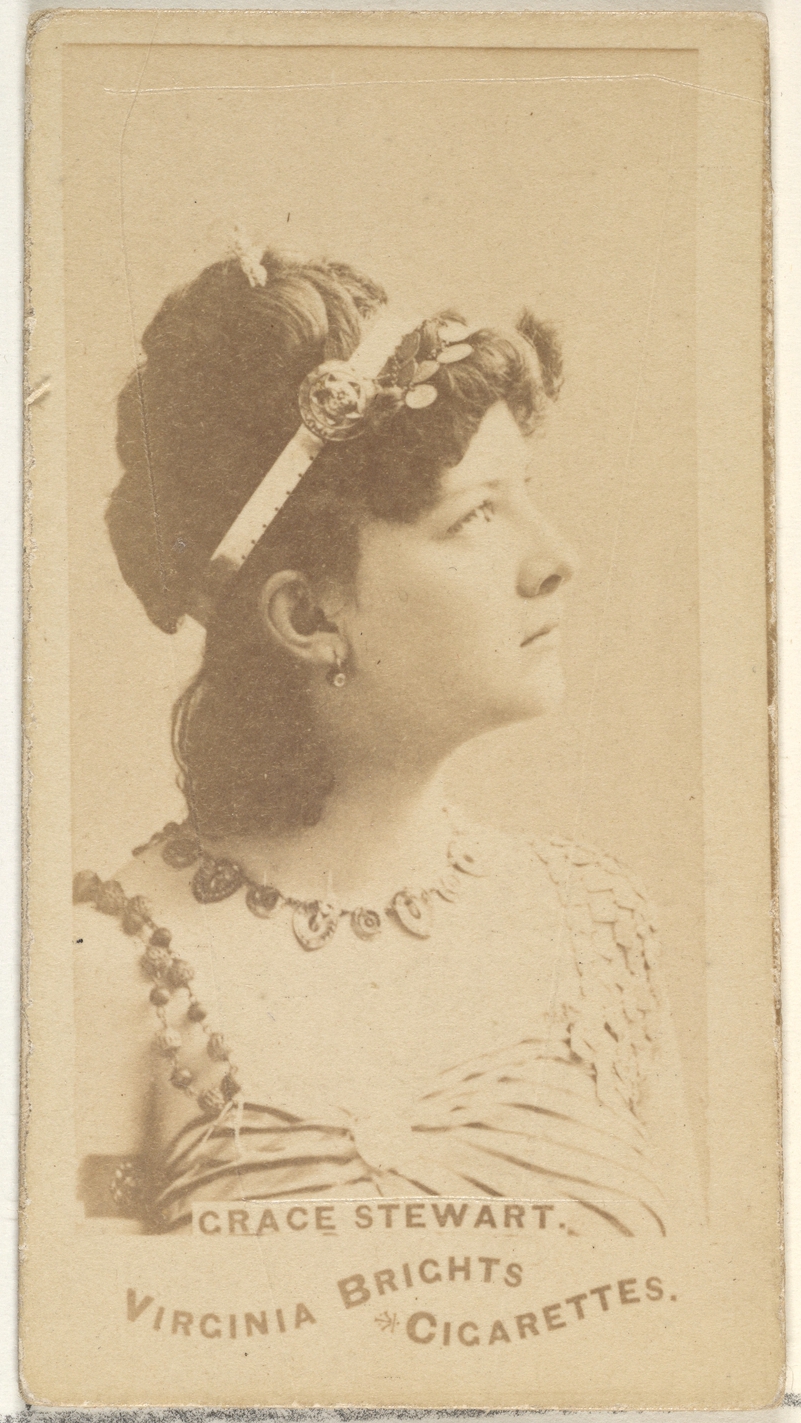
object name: photograph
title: Grace Stewart, from the Actors and Actresses series (N45, Type 1) for Virginia Brights Cigarettes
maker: allen & ginter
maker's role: publisher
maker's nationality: american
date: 1888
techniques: albumen silver print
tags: portraits,women,actresses